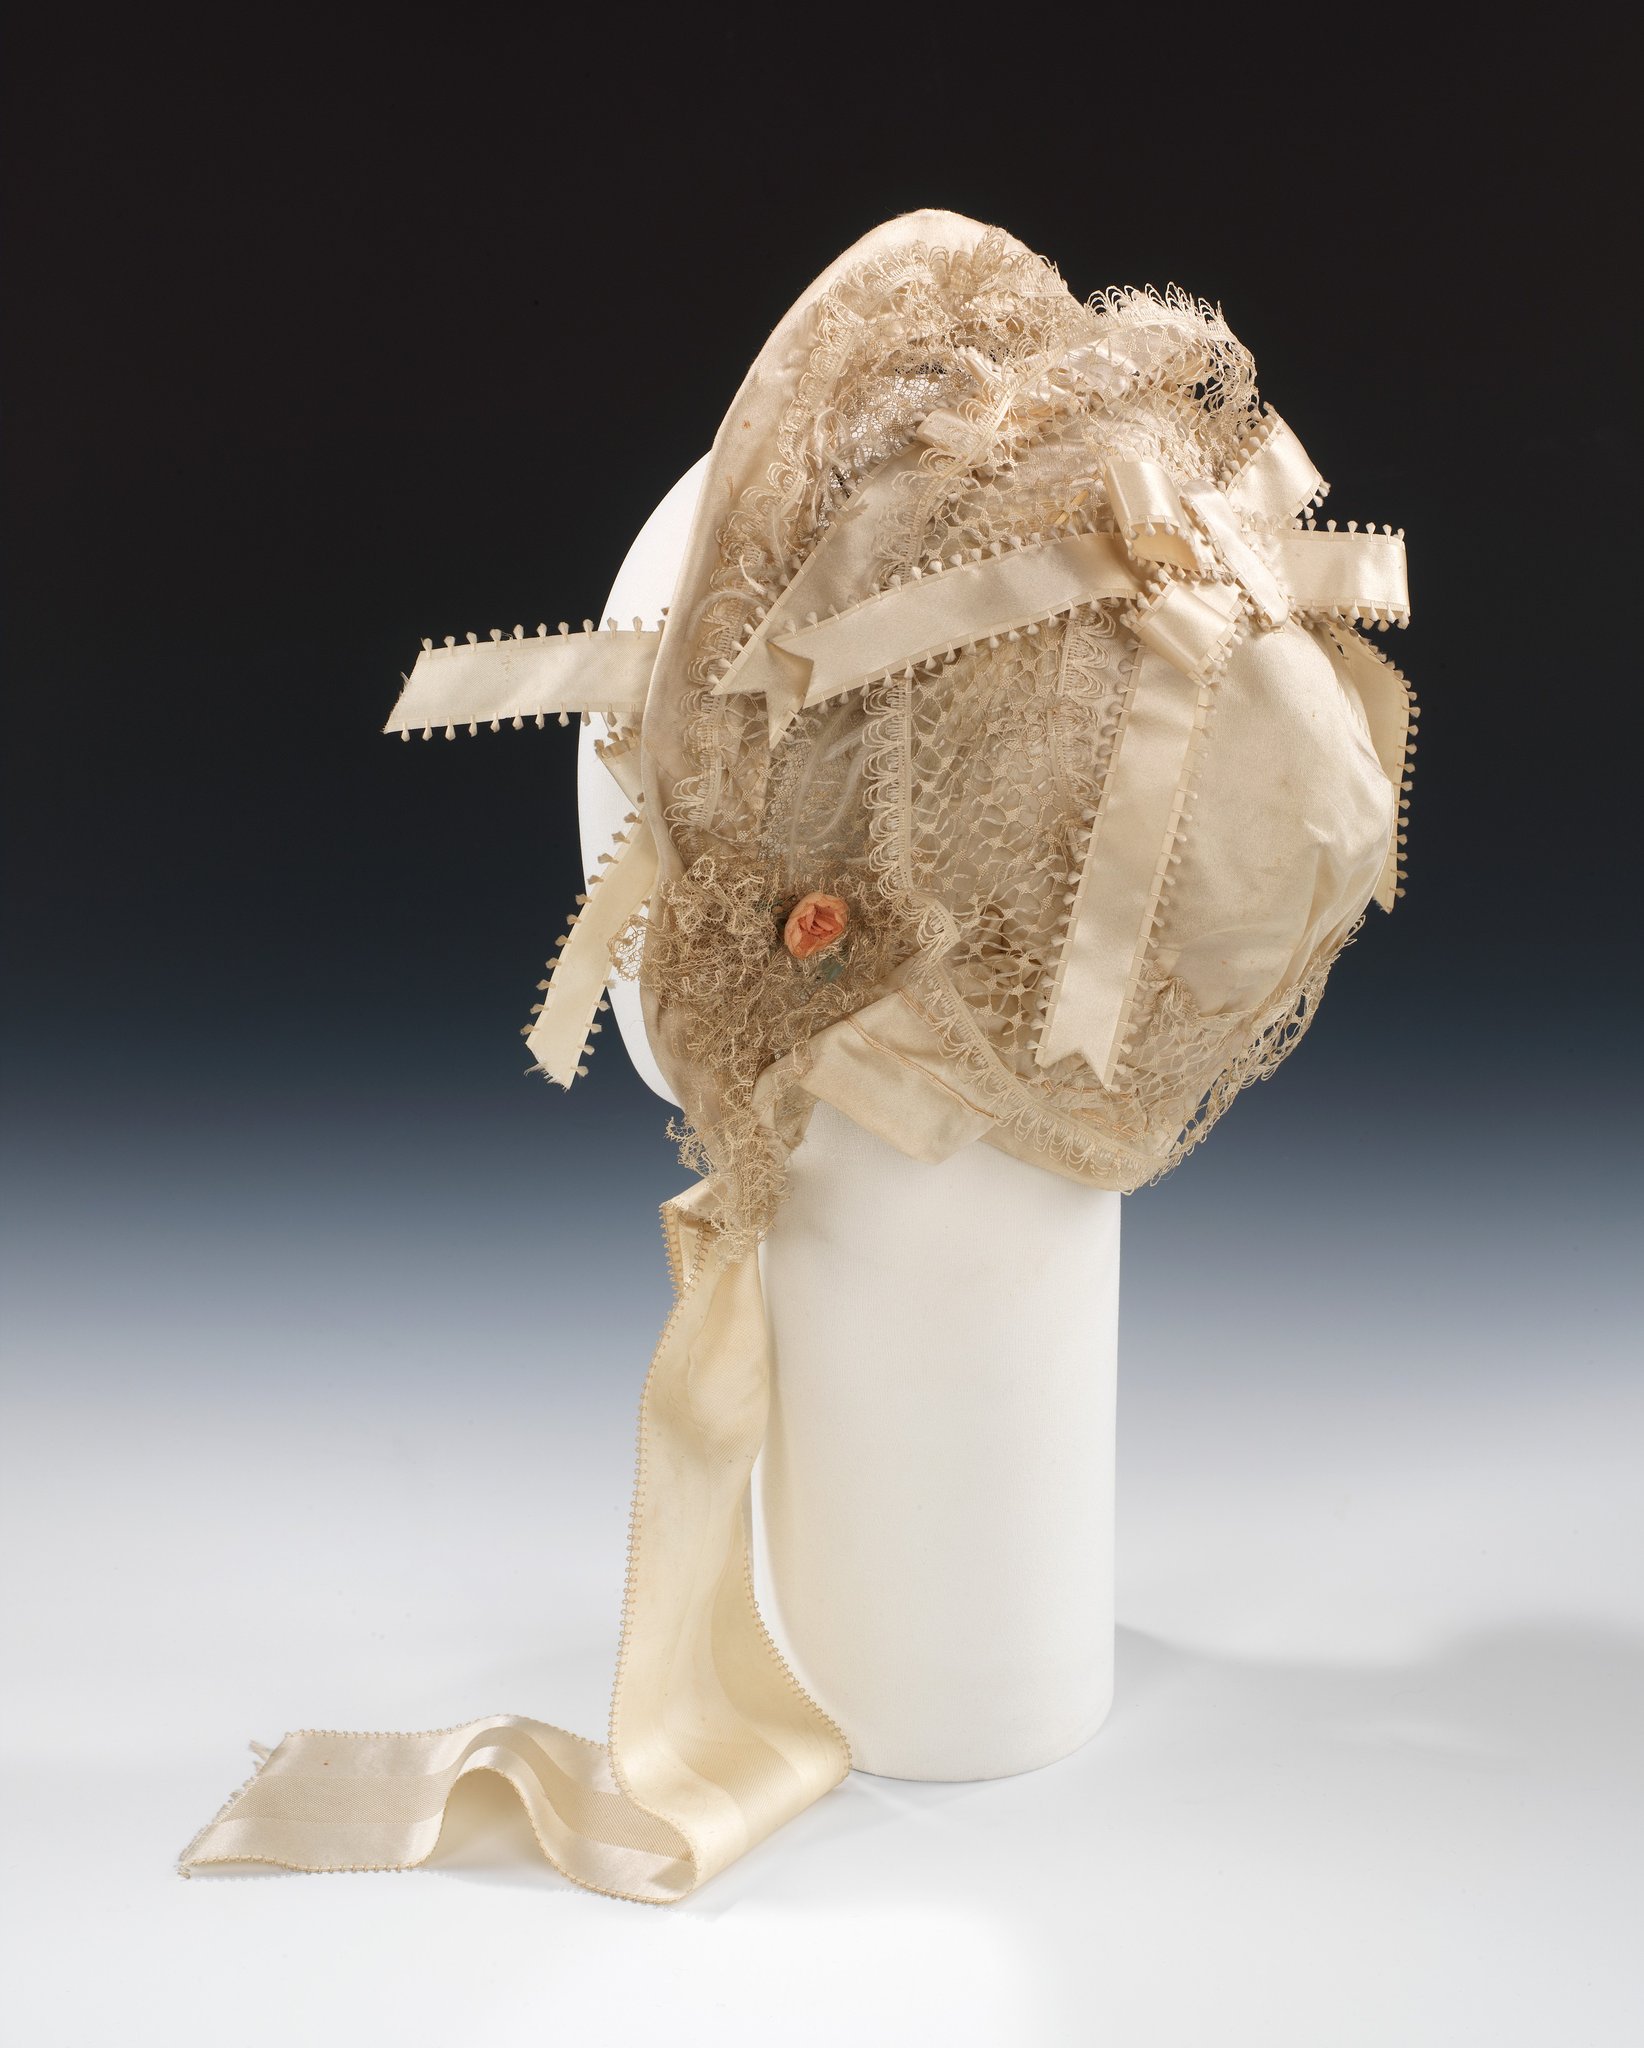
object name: bonnet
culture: american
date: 1854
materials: feather, silk